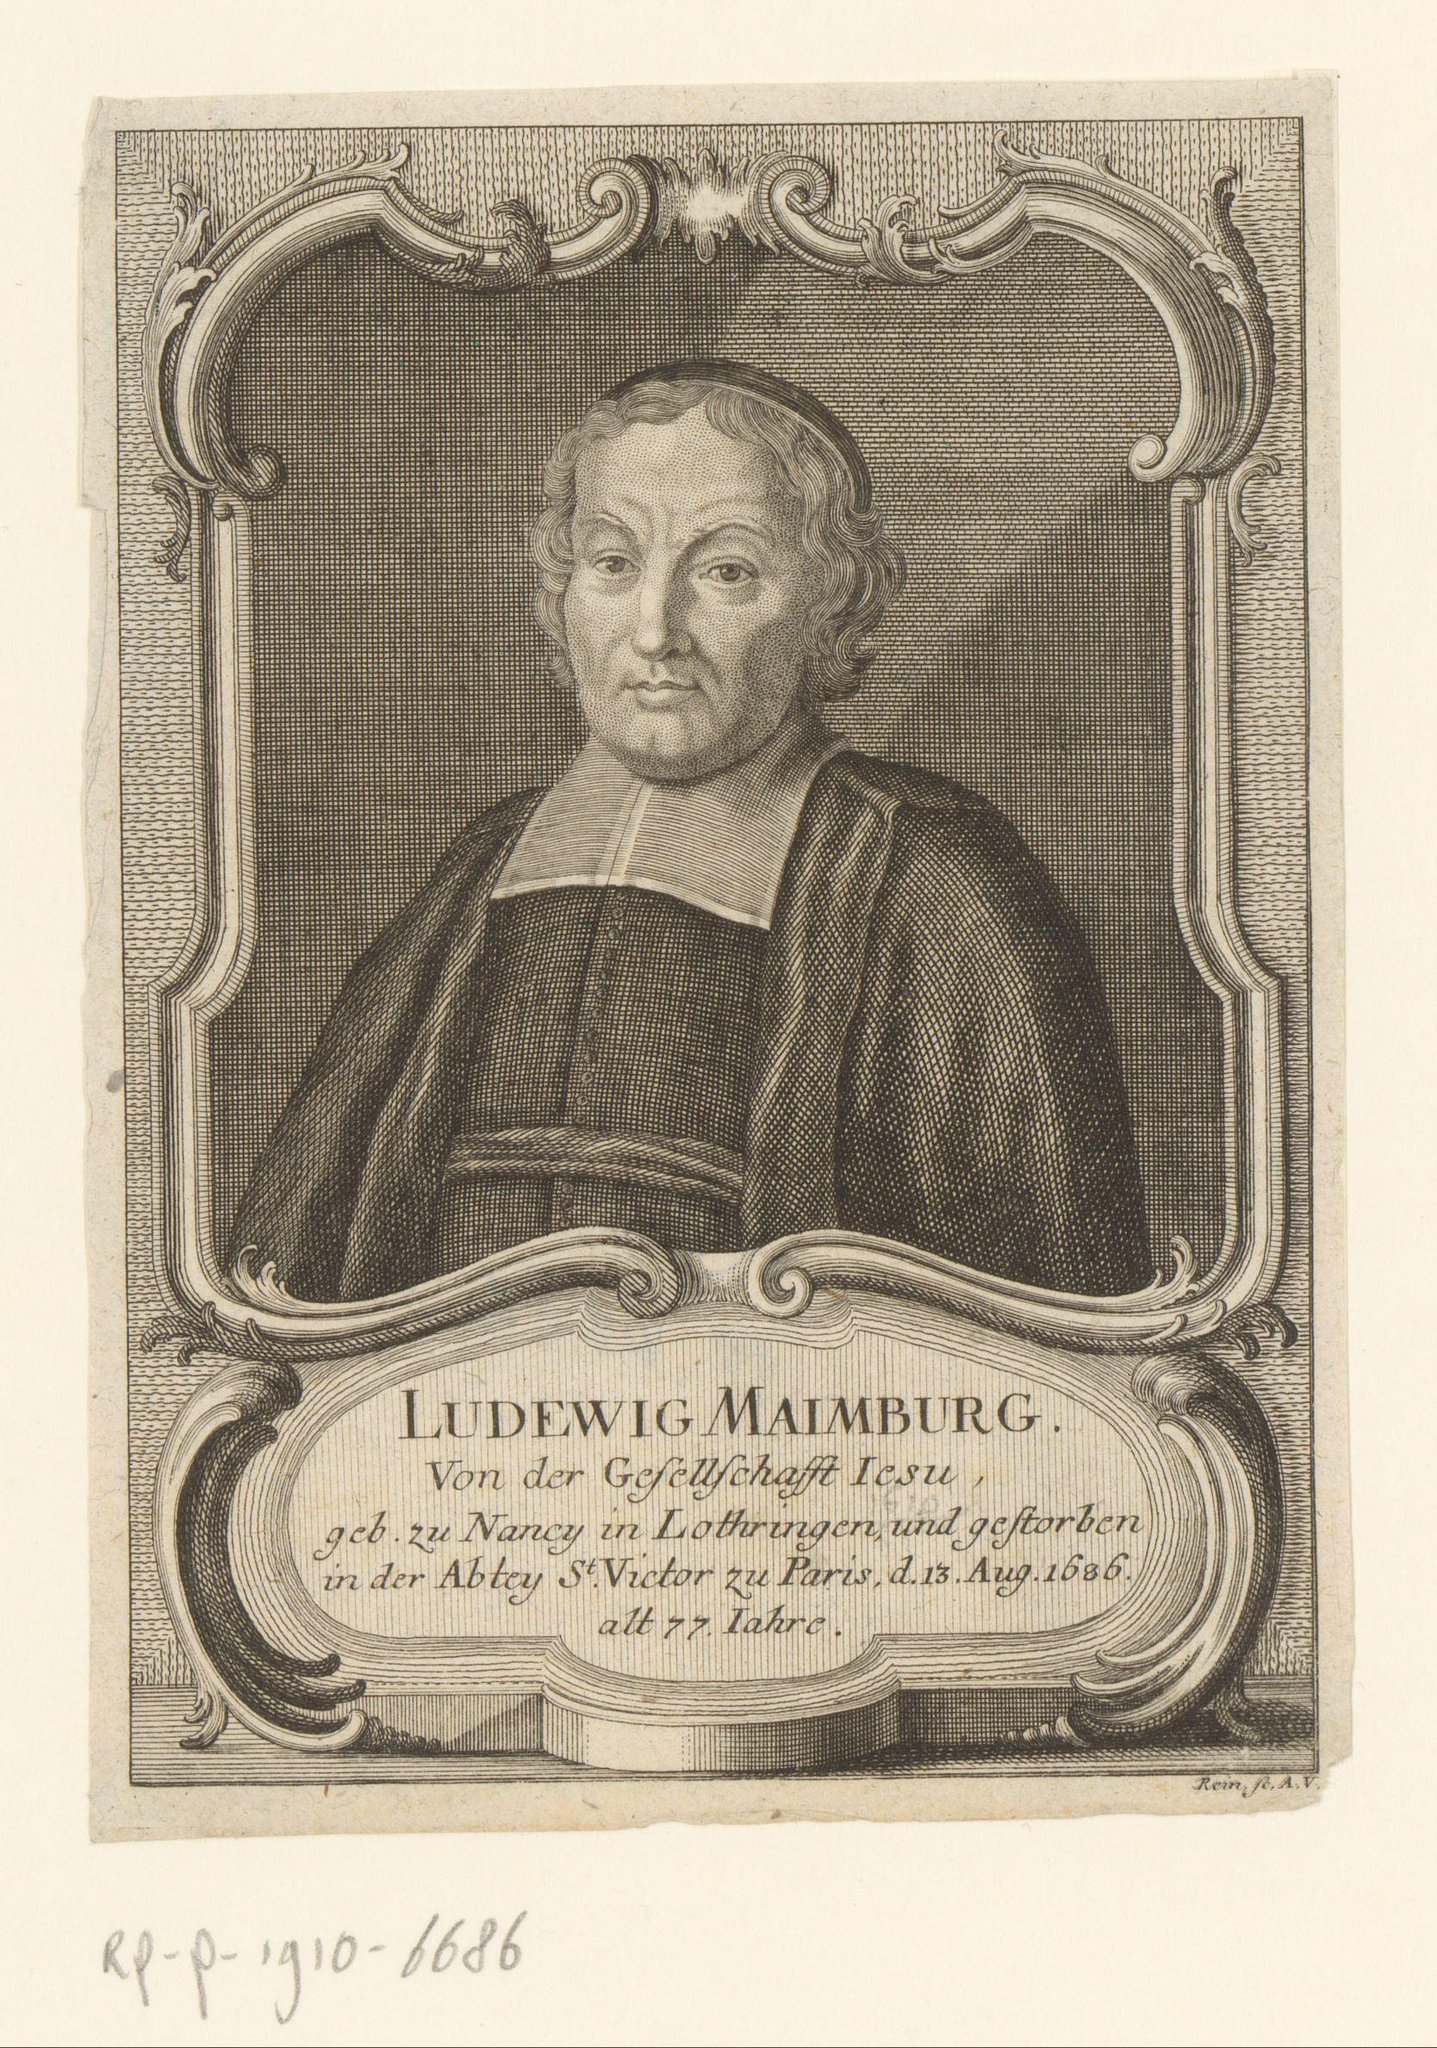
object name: print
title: Portret van Louis Maimburg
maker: melchior rein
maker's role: print maker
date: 1686-1778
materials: paper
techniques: engraving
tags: clergyman, theologian, historical persons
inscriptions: collector's mark: Lugt 2228